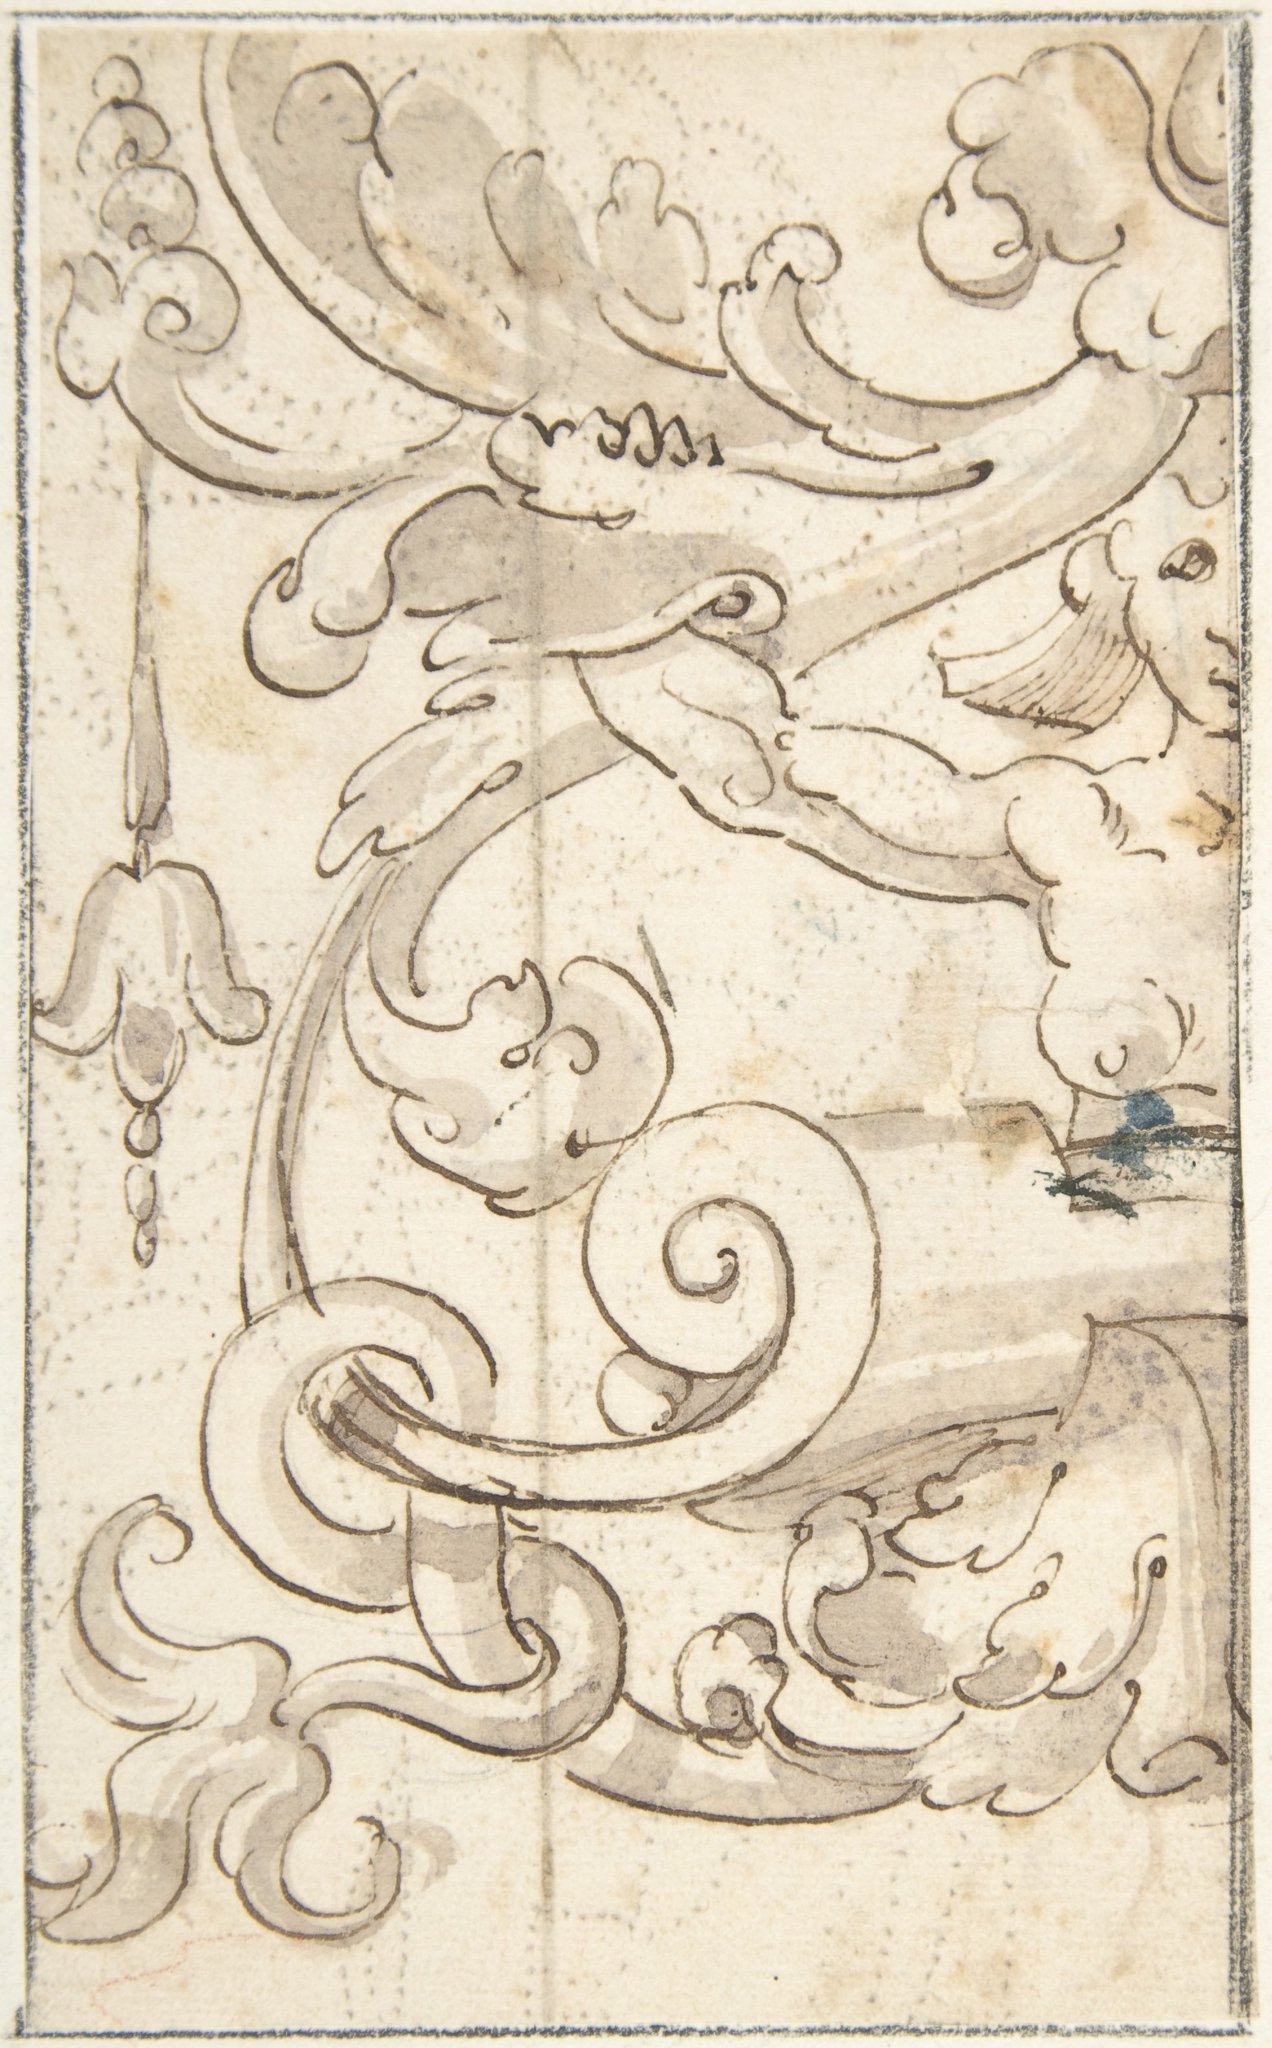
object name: drawing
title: Fragment of Ornamental Drawing after the Antique; Half-harpy with Acanthus Rinceaux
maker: andrés de melgar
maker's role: artist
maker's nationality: spanish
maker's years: 1554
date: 1545-1560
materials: ink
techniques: brush, pen, wash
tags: ornament,acanthus